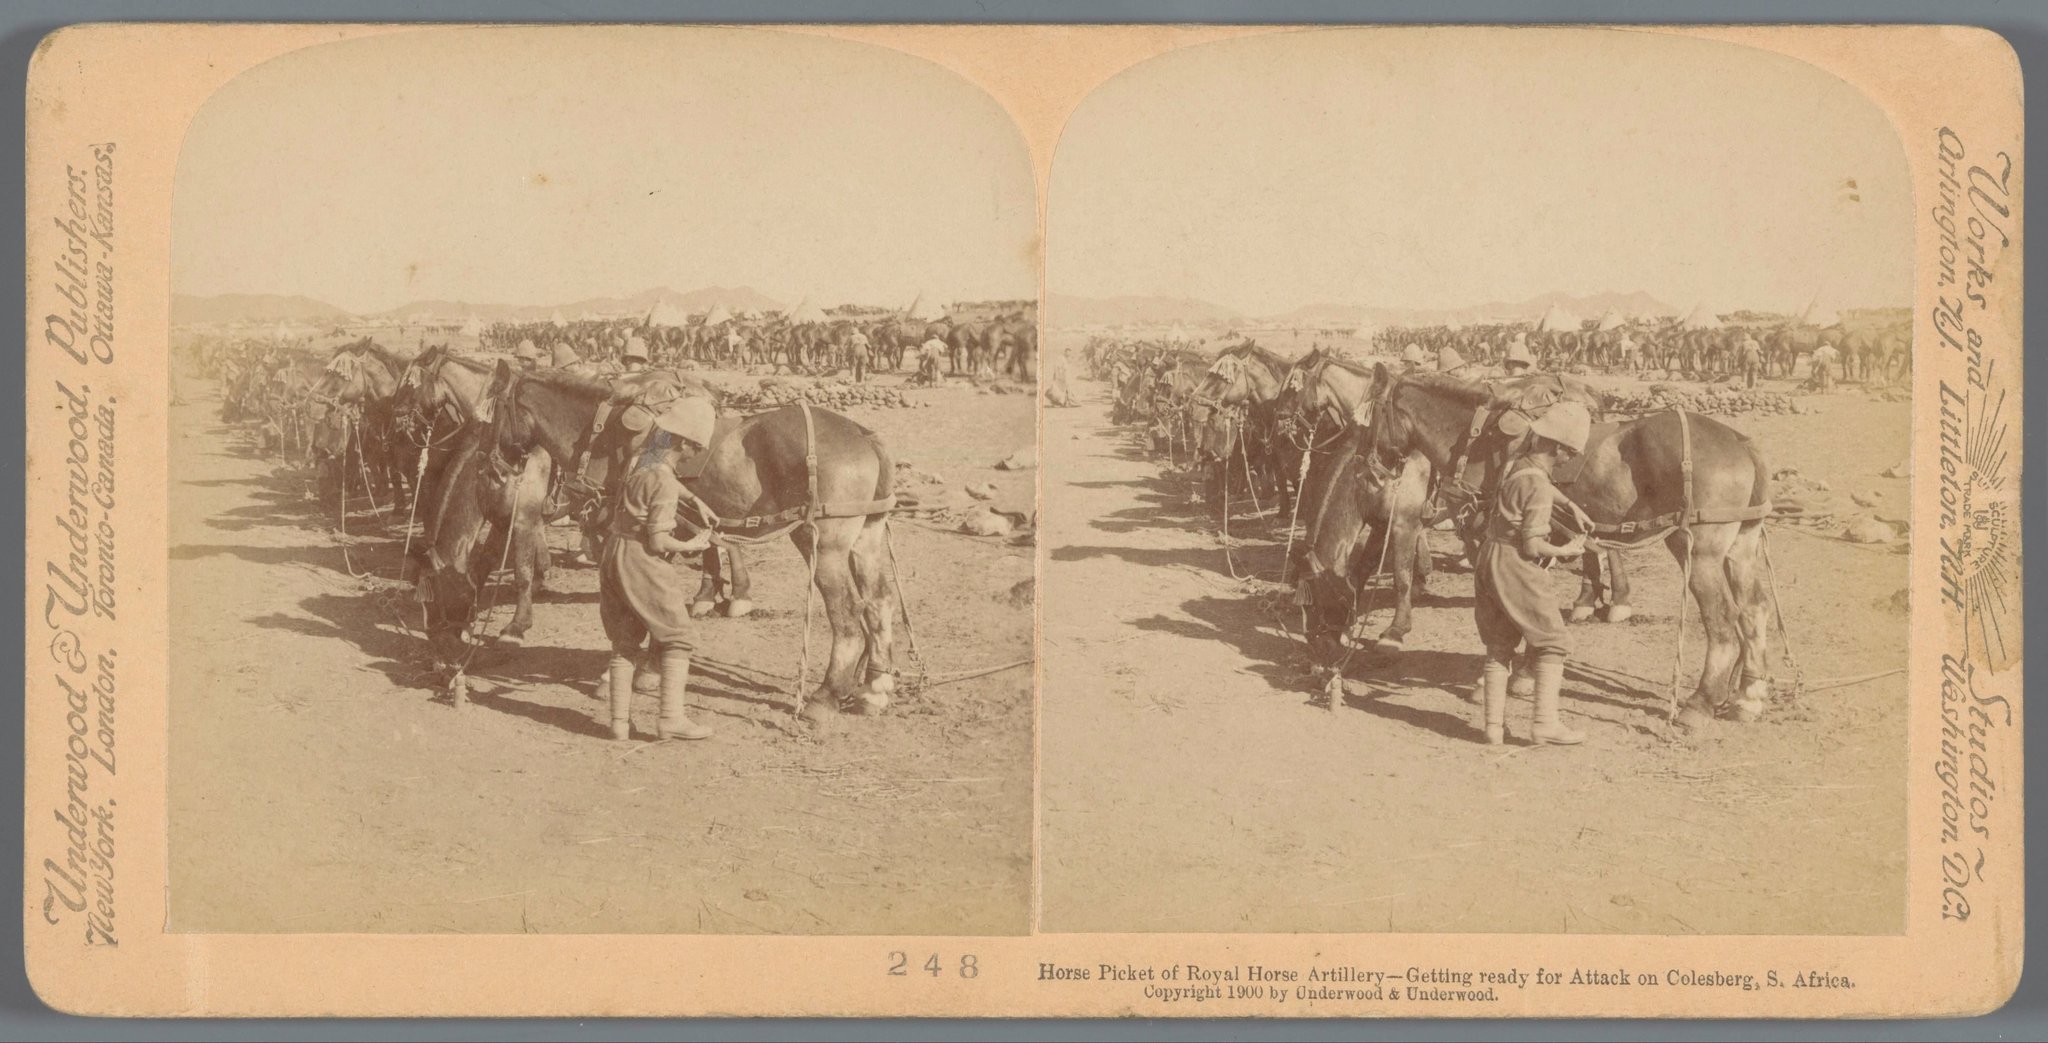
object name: stereograph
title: Horse Picket of Royal Horse Artillery - Getting ready for Attack on Colesberg, S. Africa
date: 1900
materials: cardboard, photographic support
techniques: albumen print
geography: south africa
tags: the soldier; the soldier's life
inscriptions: number: ‘248’, name: ‘Works and Studios Sun Sculpture trade mark Arlington N.J. Littleton N.H. Washington D.C.’